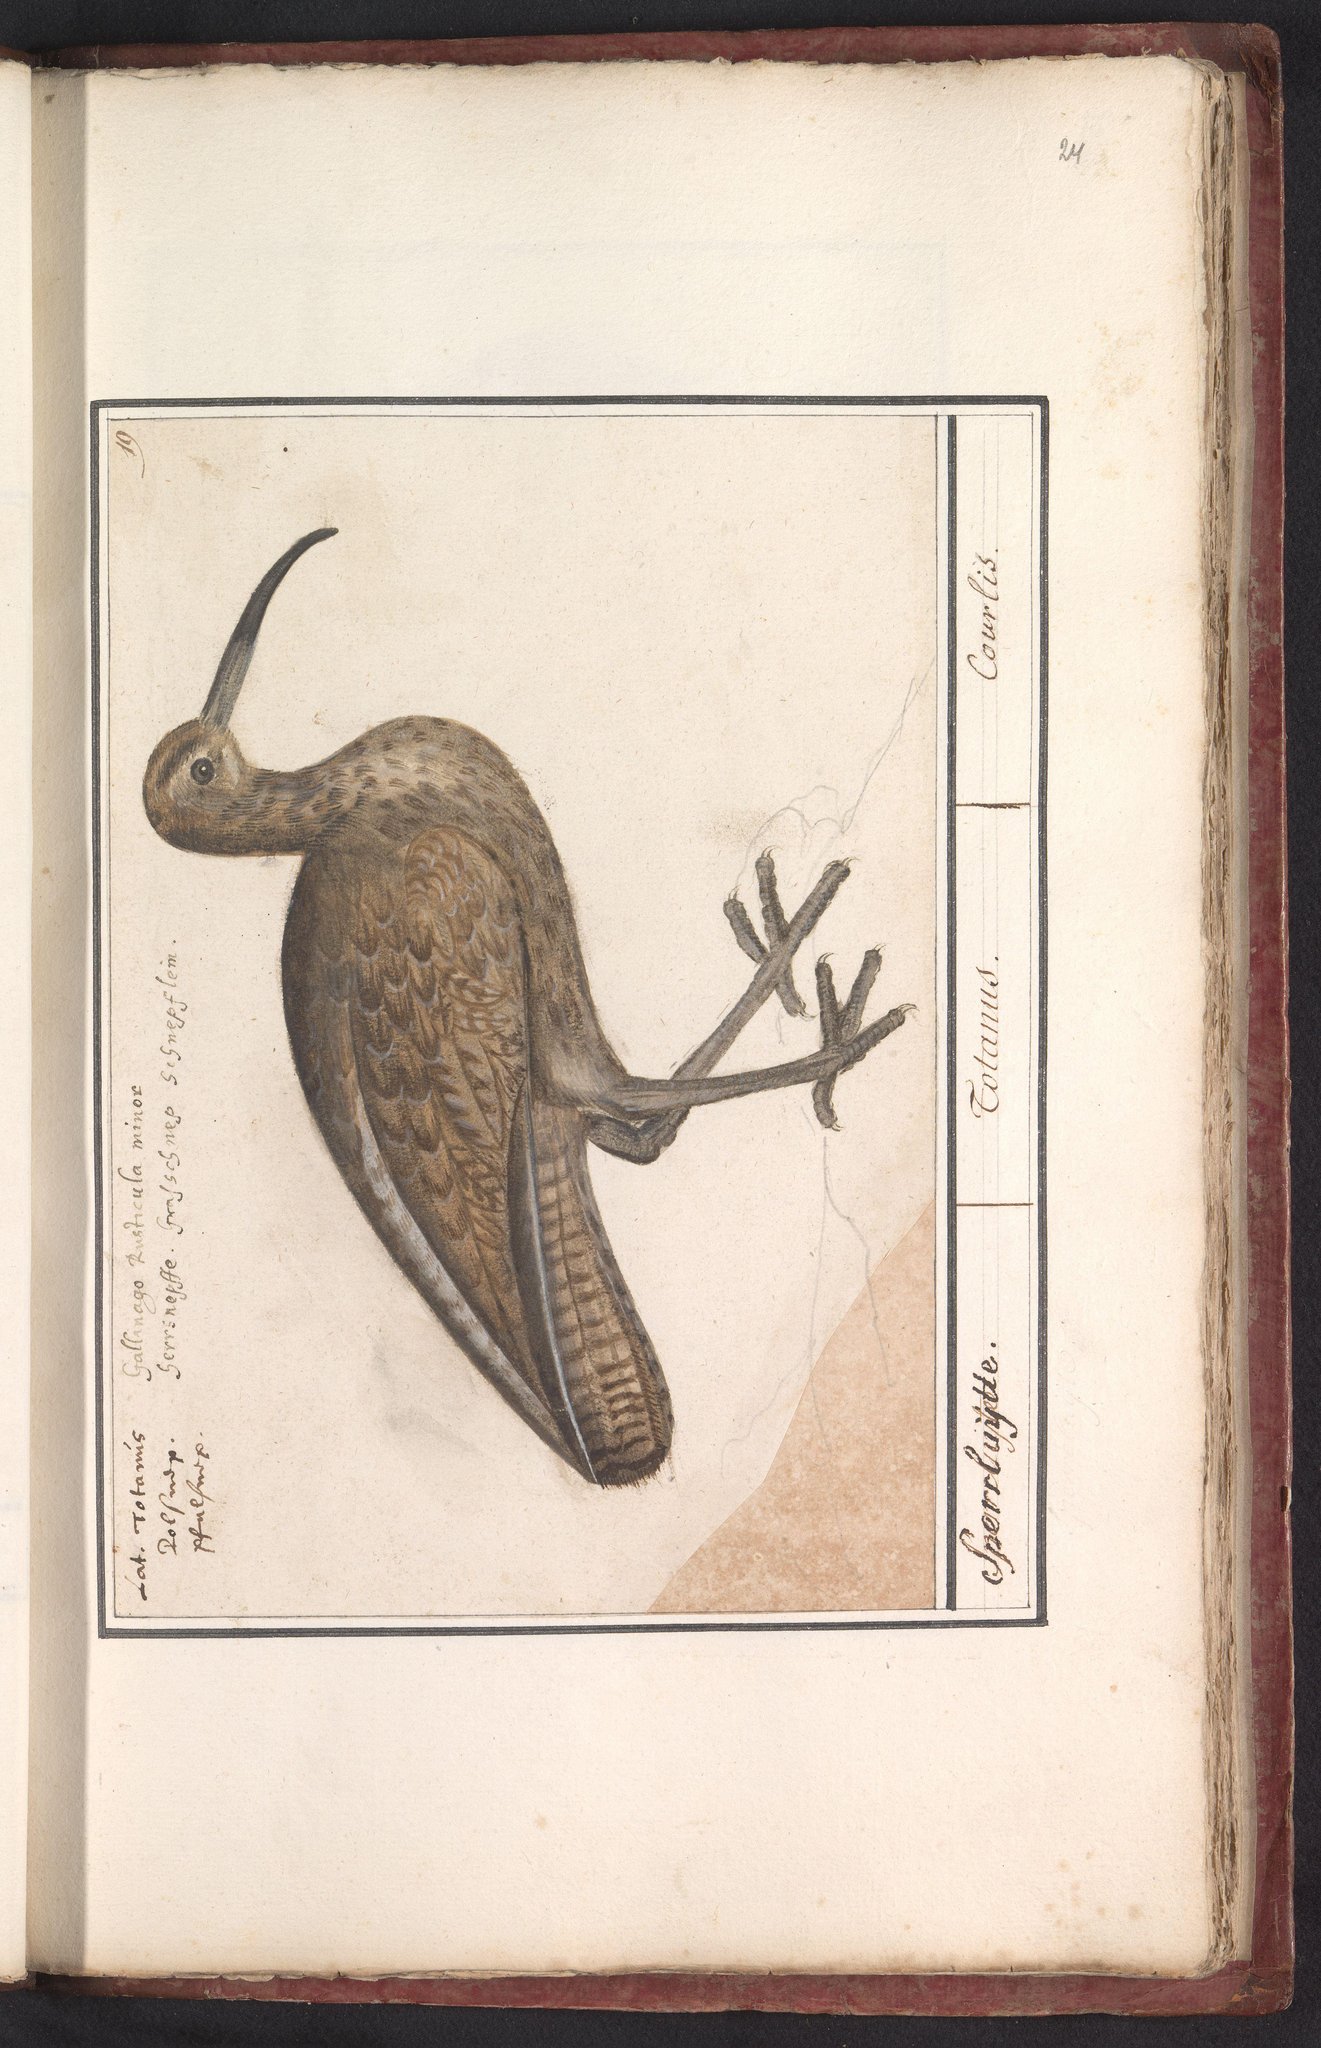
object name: drawing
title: Wulp (Numenius arquata)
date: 1596-1610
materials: chalk, paint, ink, paper, pencil, watercolor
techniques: brush, pen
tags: shore-birds and wading-birds: curlew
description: Wulp. Genummerd rechtsboven: 19. Linksboven de naam in verschillende talen. Onderdeel van het derde album met tekeningen van vogels. Vijfde van twaalf albums met tekeningen van dieren, vogels en planten bekend rond 1600, gemaakt in opdracht van keizer Rudolf II. Met toelichting in Nederlands, Latijn en Frans.